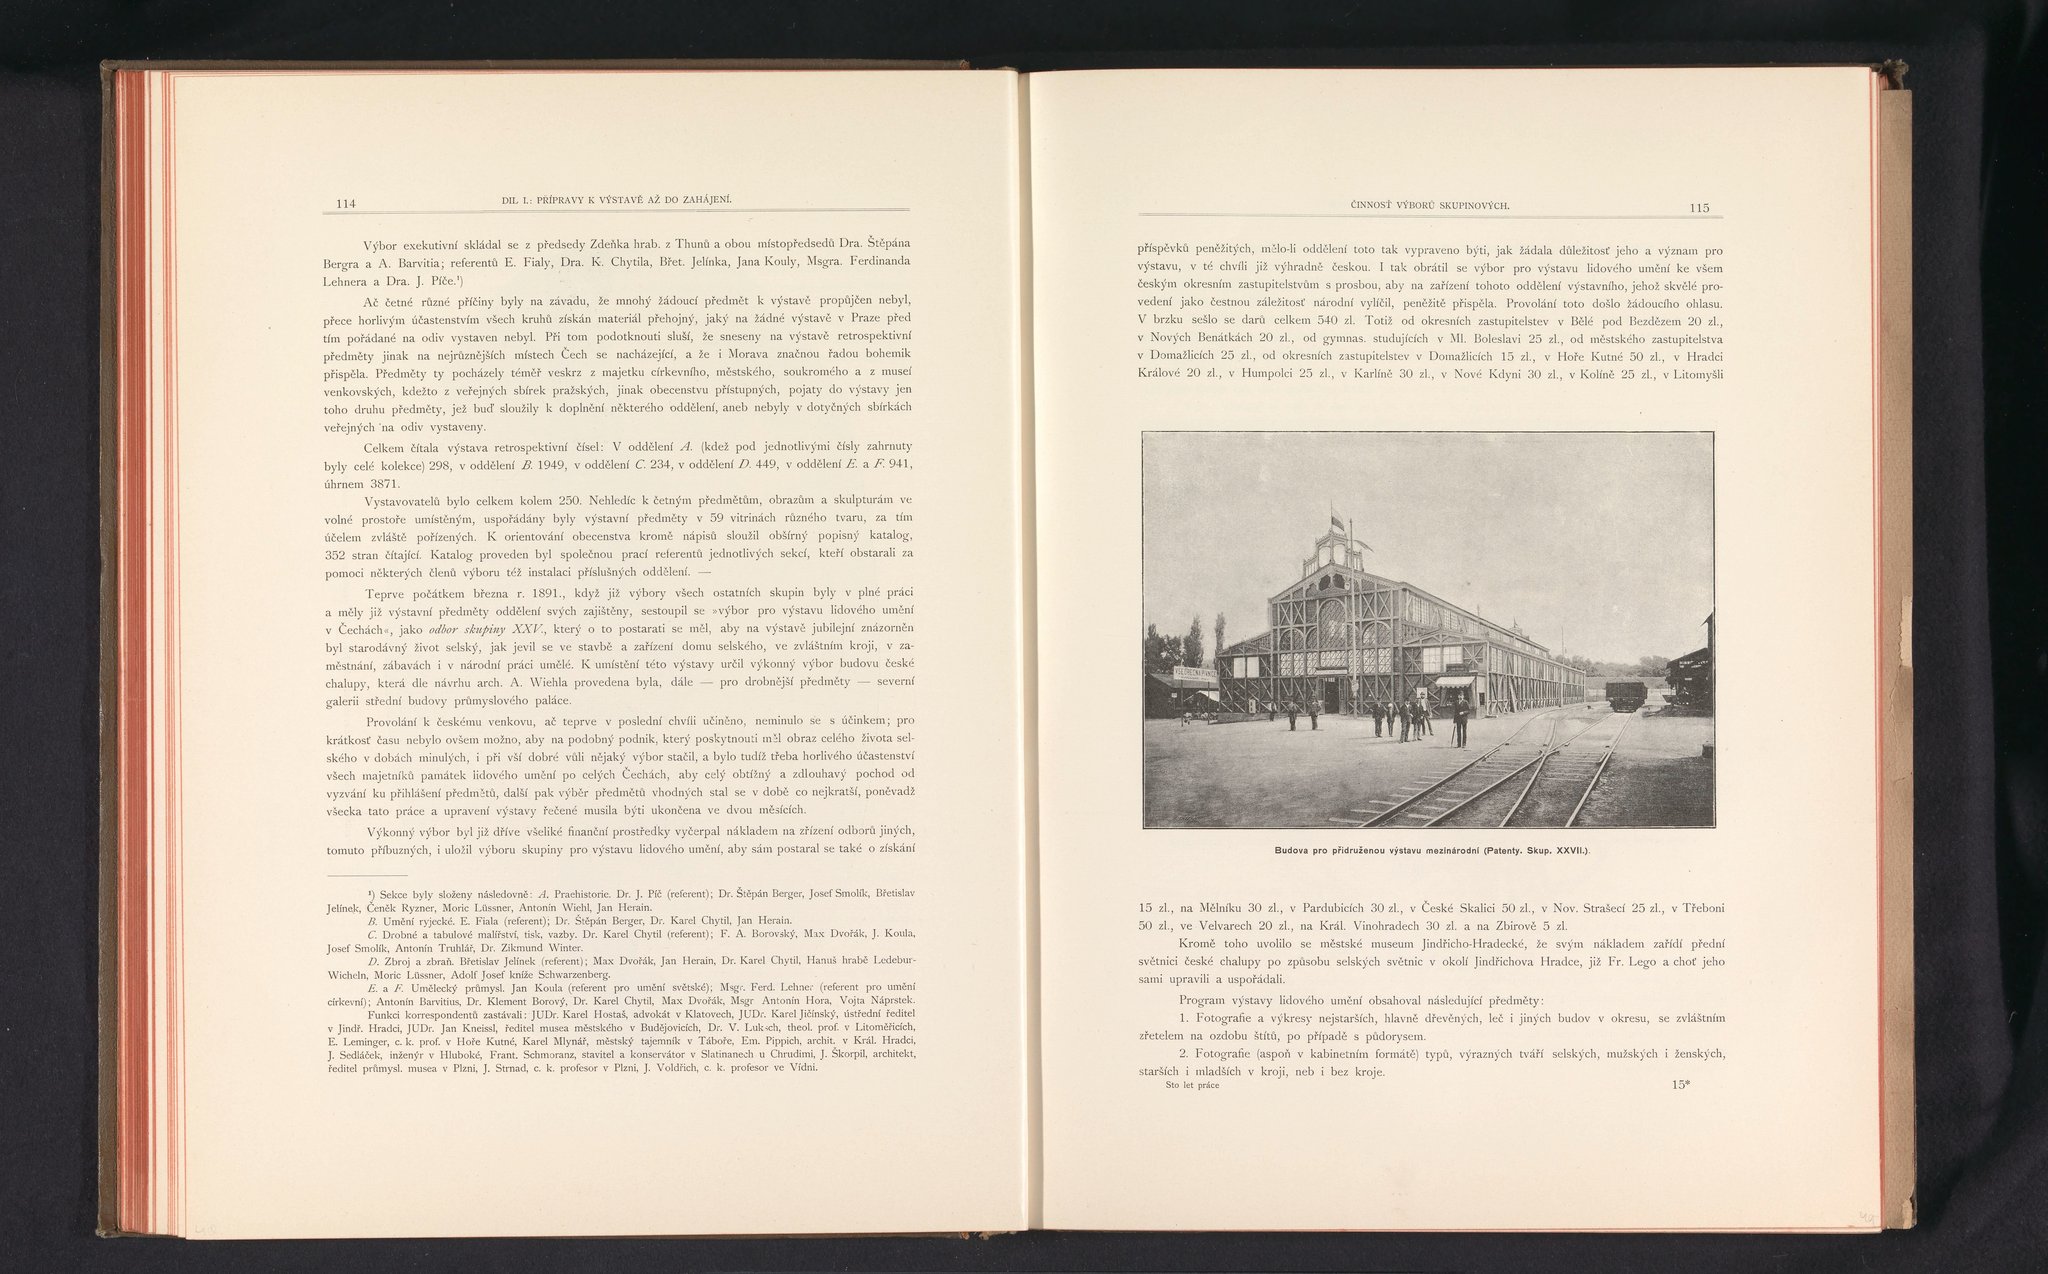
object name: photomechanical print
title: Budova pro pridruzenou výstavu mezinárodní (Patenty. Skup. XXVII.)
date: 1888-1893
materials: paper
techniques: autotype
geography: prague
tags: façade (of house or building), temporary exhibition, 'salon'